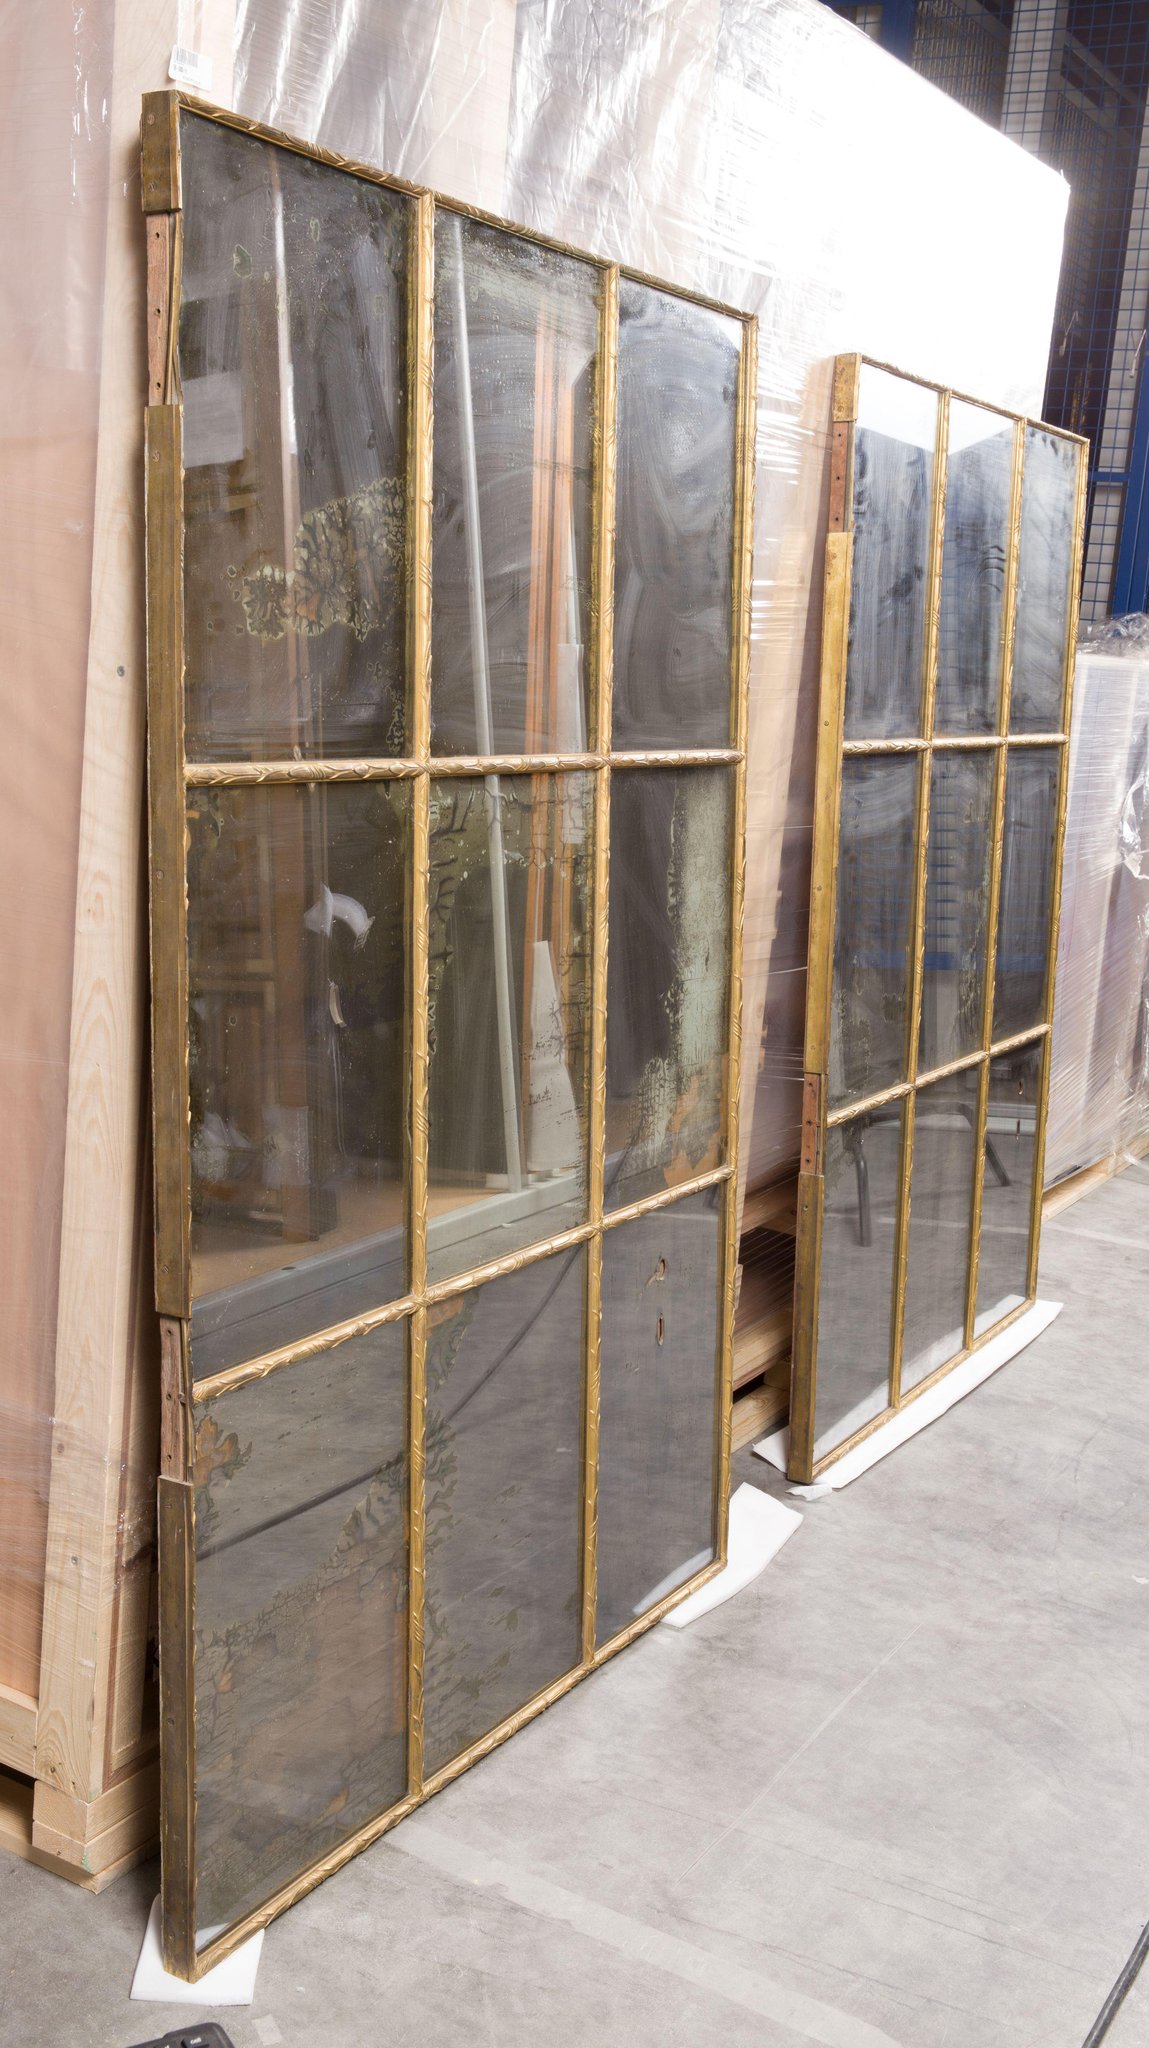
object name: architectural element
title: Interieuronderdeel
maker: Anonymous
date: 1700-1750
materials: glass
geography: france